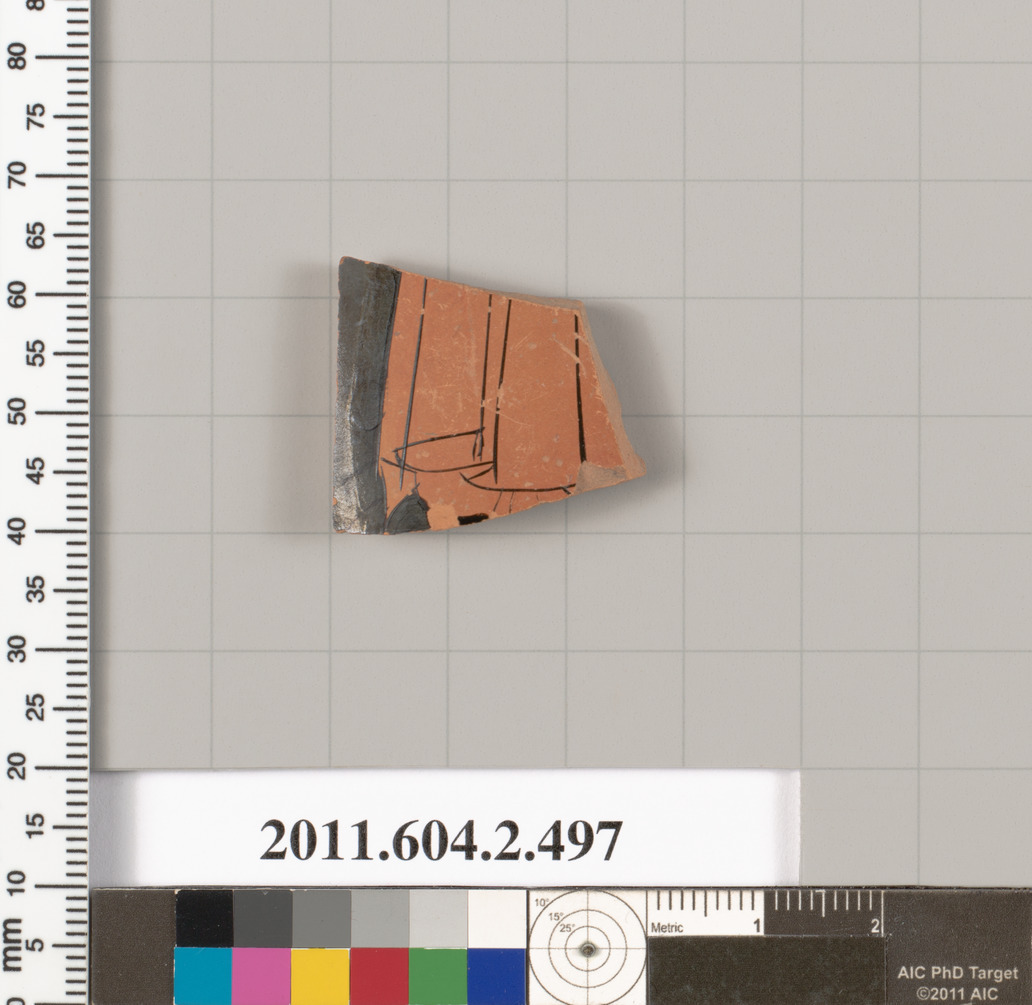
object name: column krater fragment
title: Terracotta fragment of a column-krater (bowl for mixing wine and water)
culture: greek, attic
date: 460-440 BCE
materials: terracotta